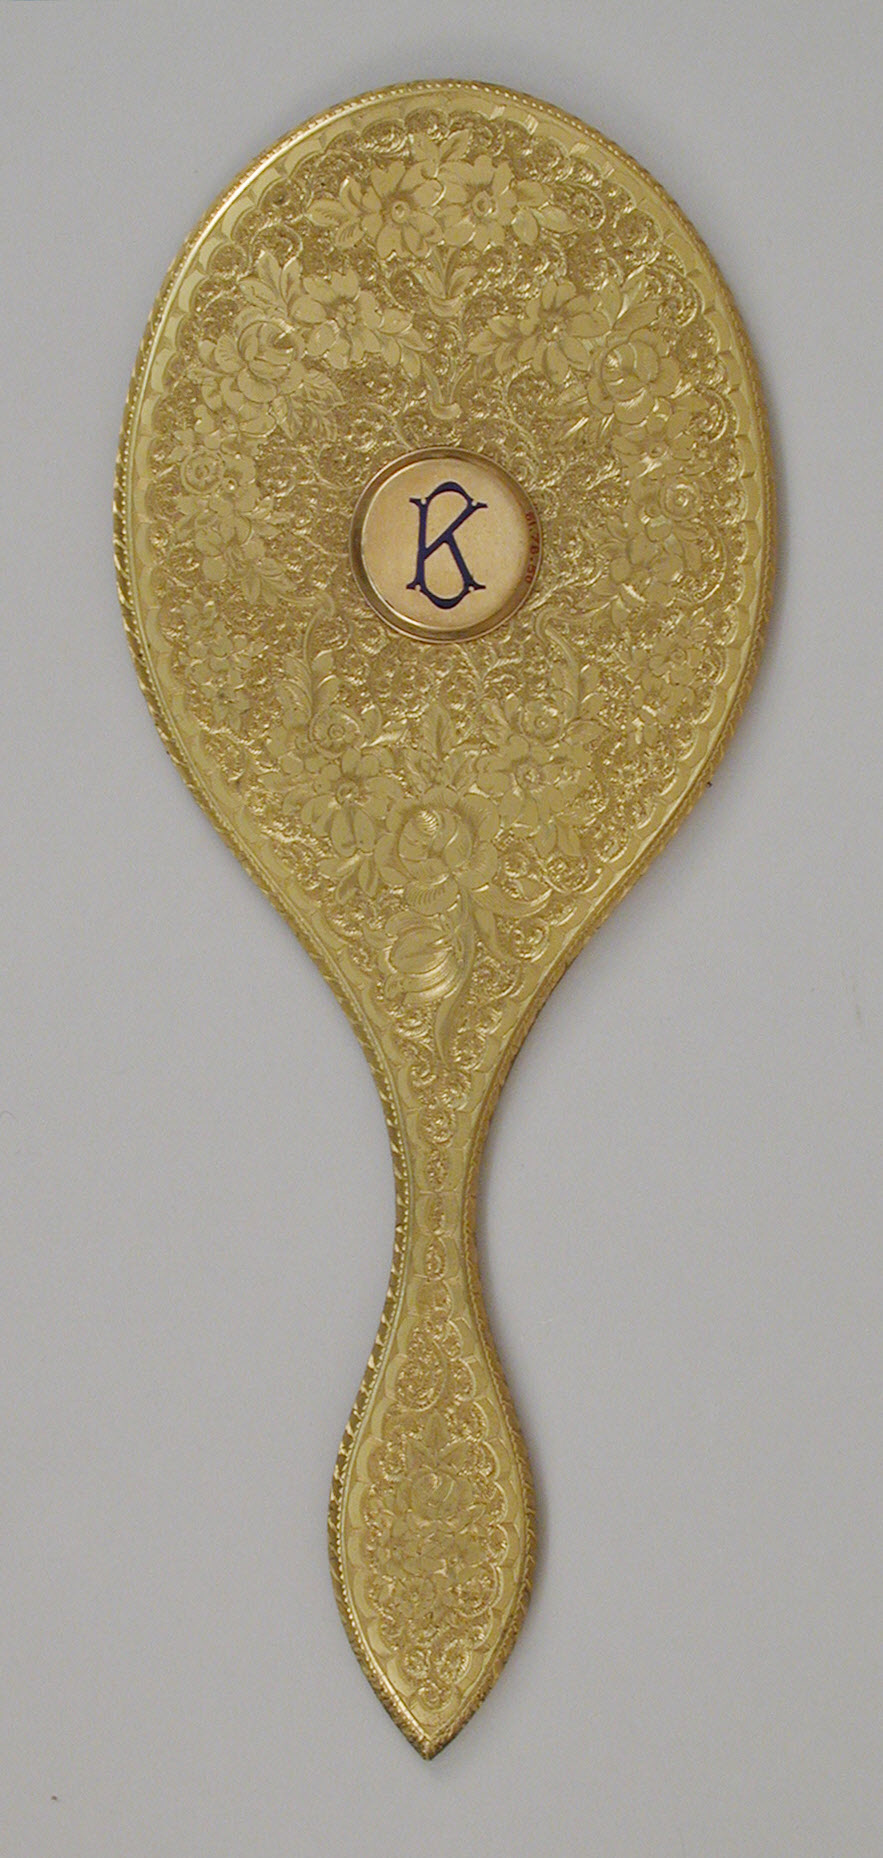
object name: hand mirror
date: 1867-1900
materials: glass, silver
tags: flowers